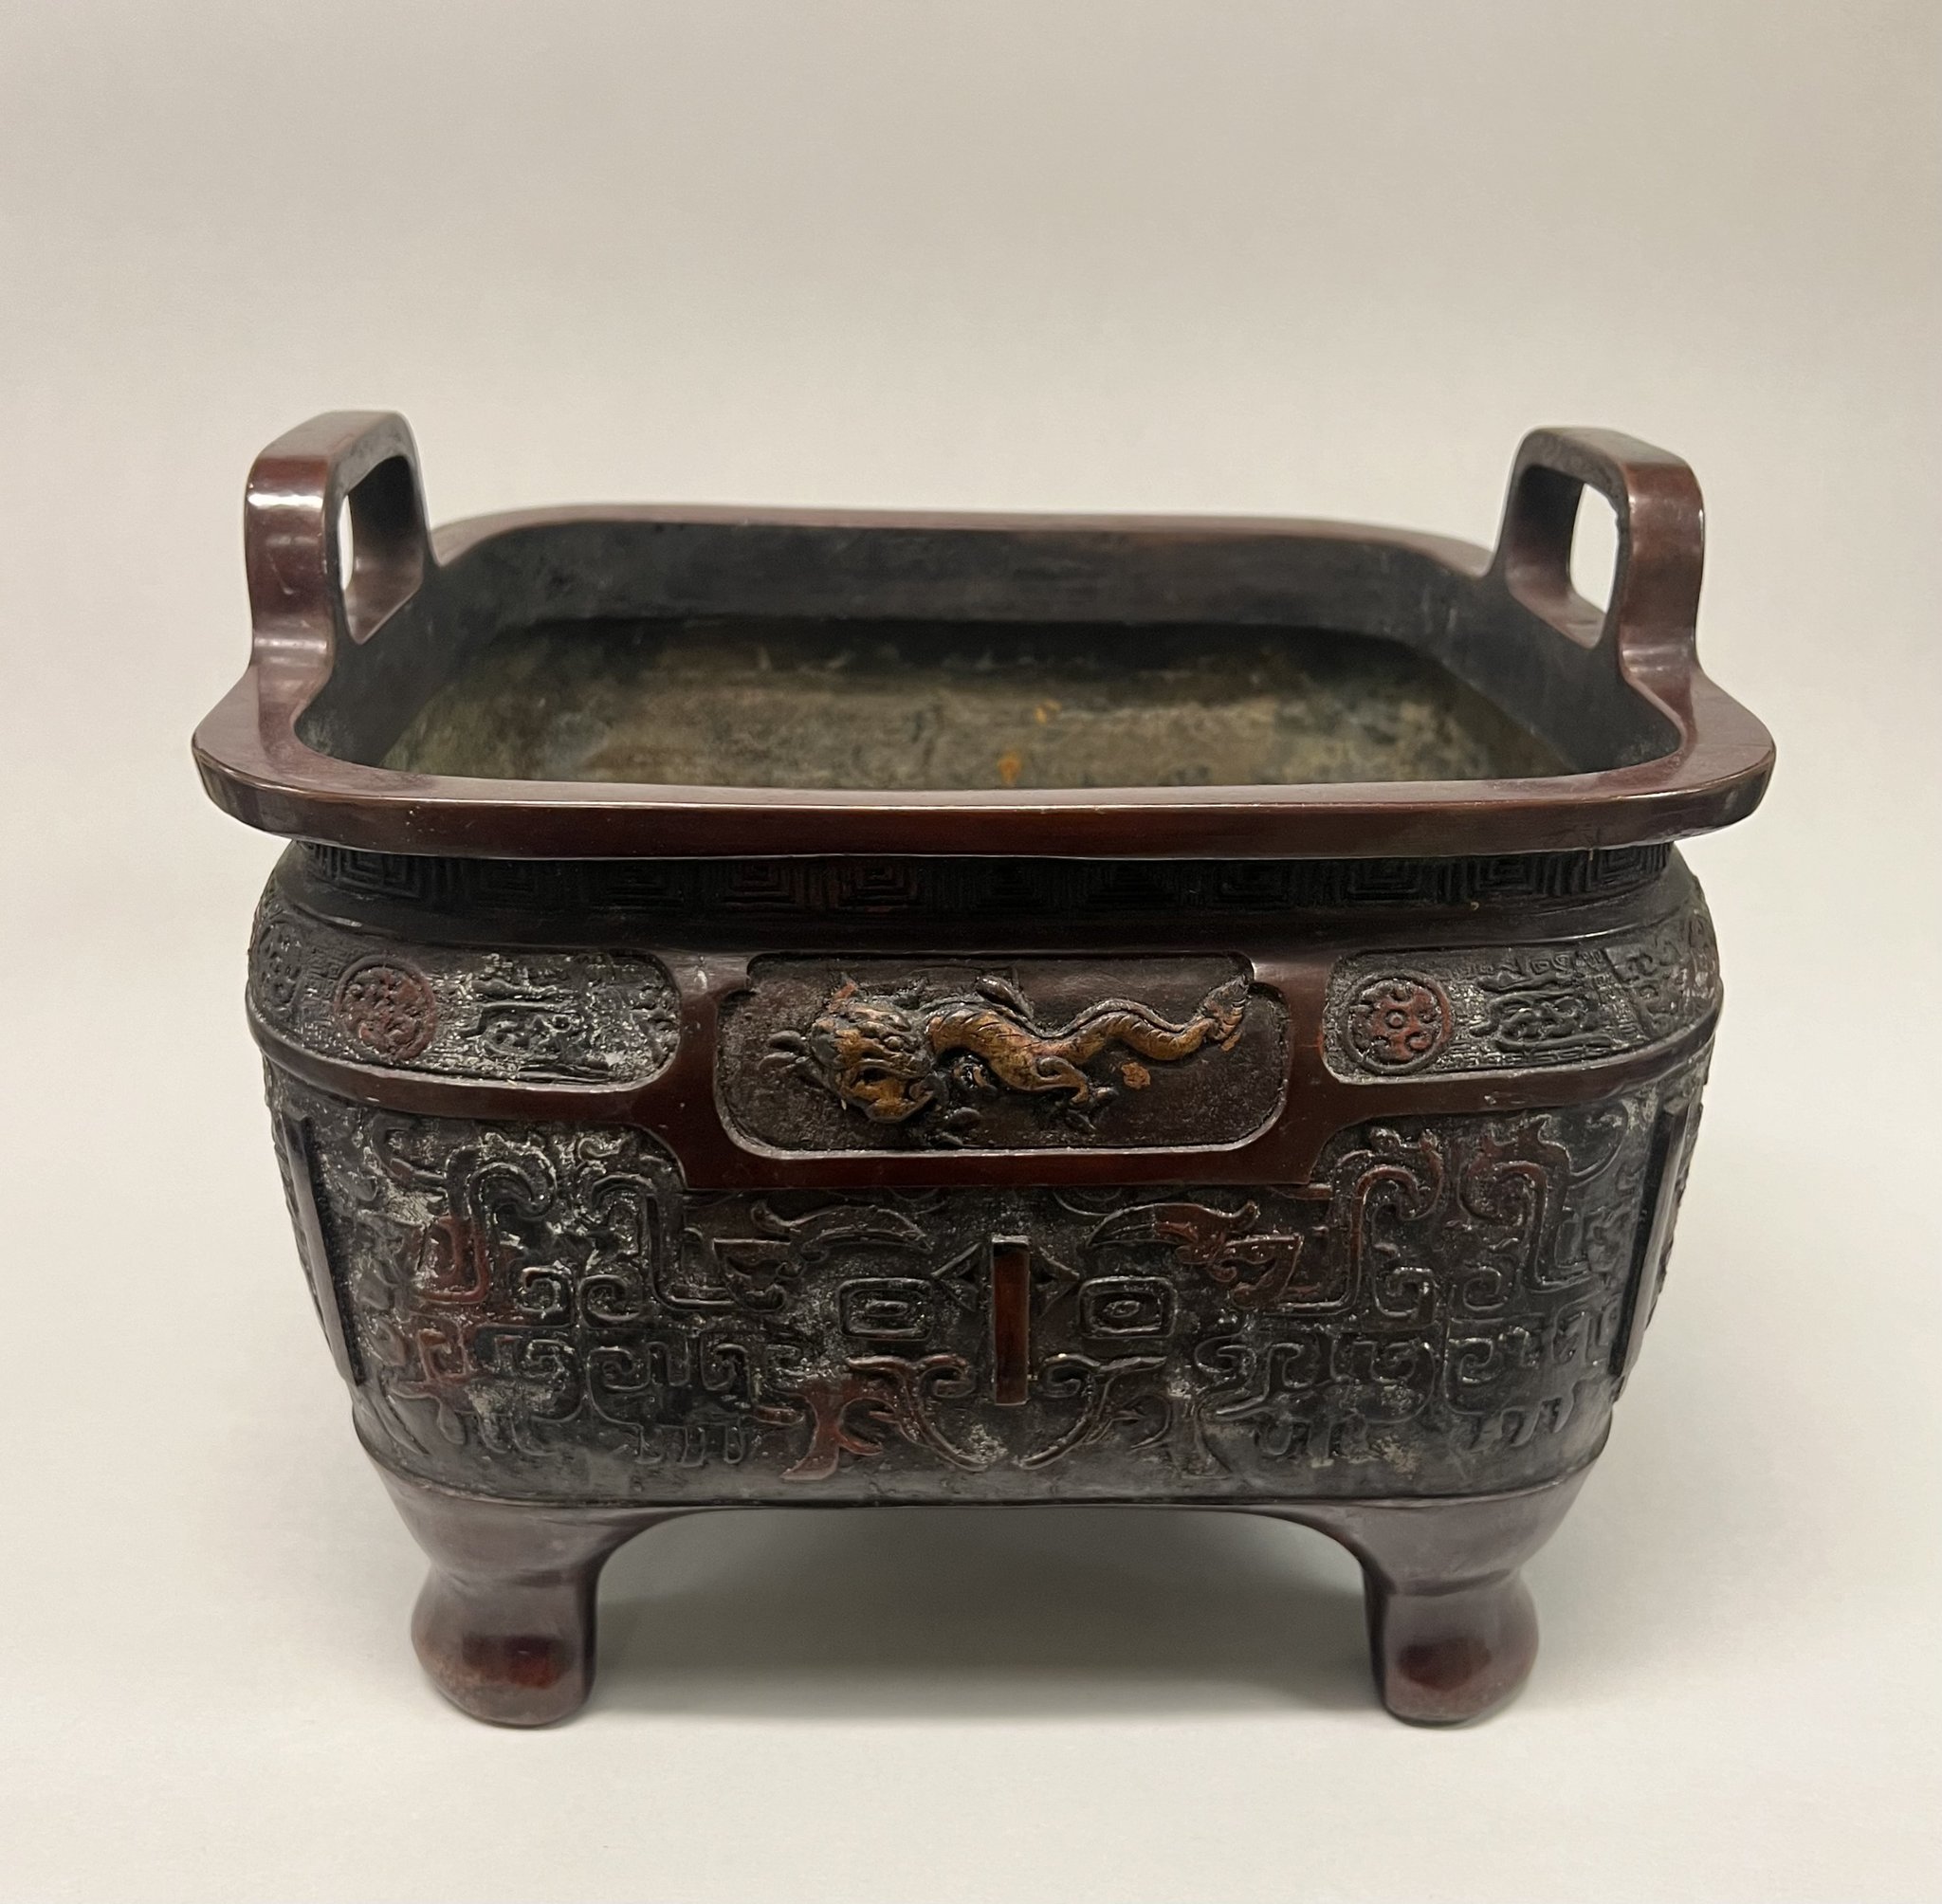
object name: incense burner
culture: chinese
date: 1426-1435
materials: bronze